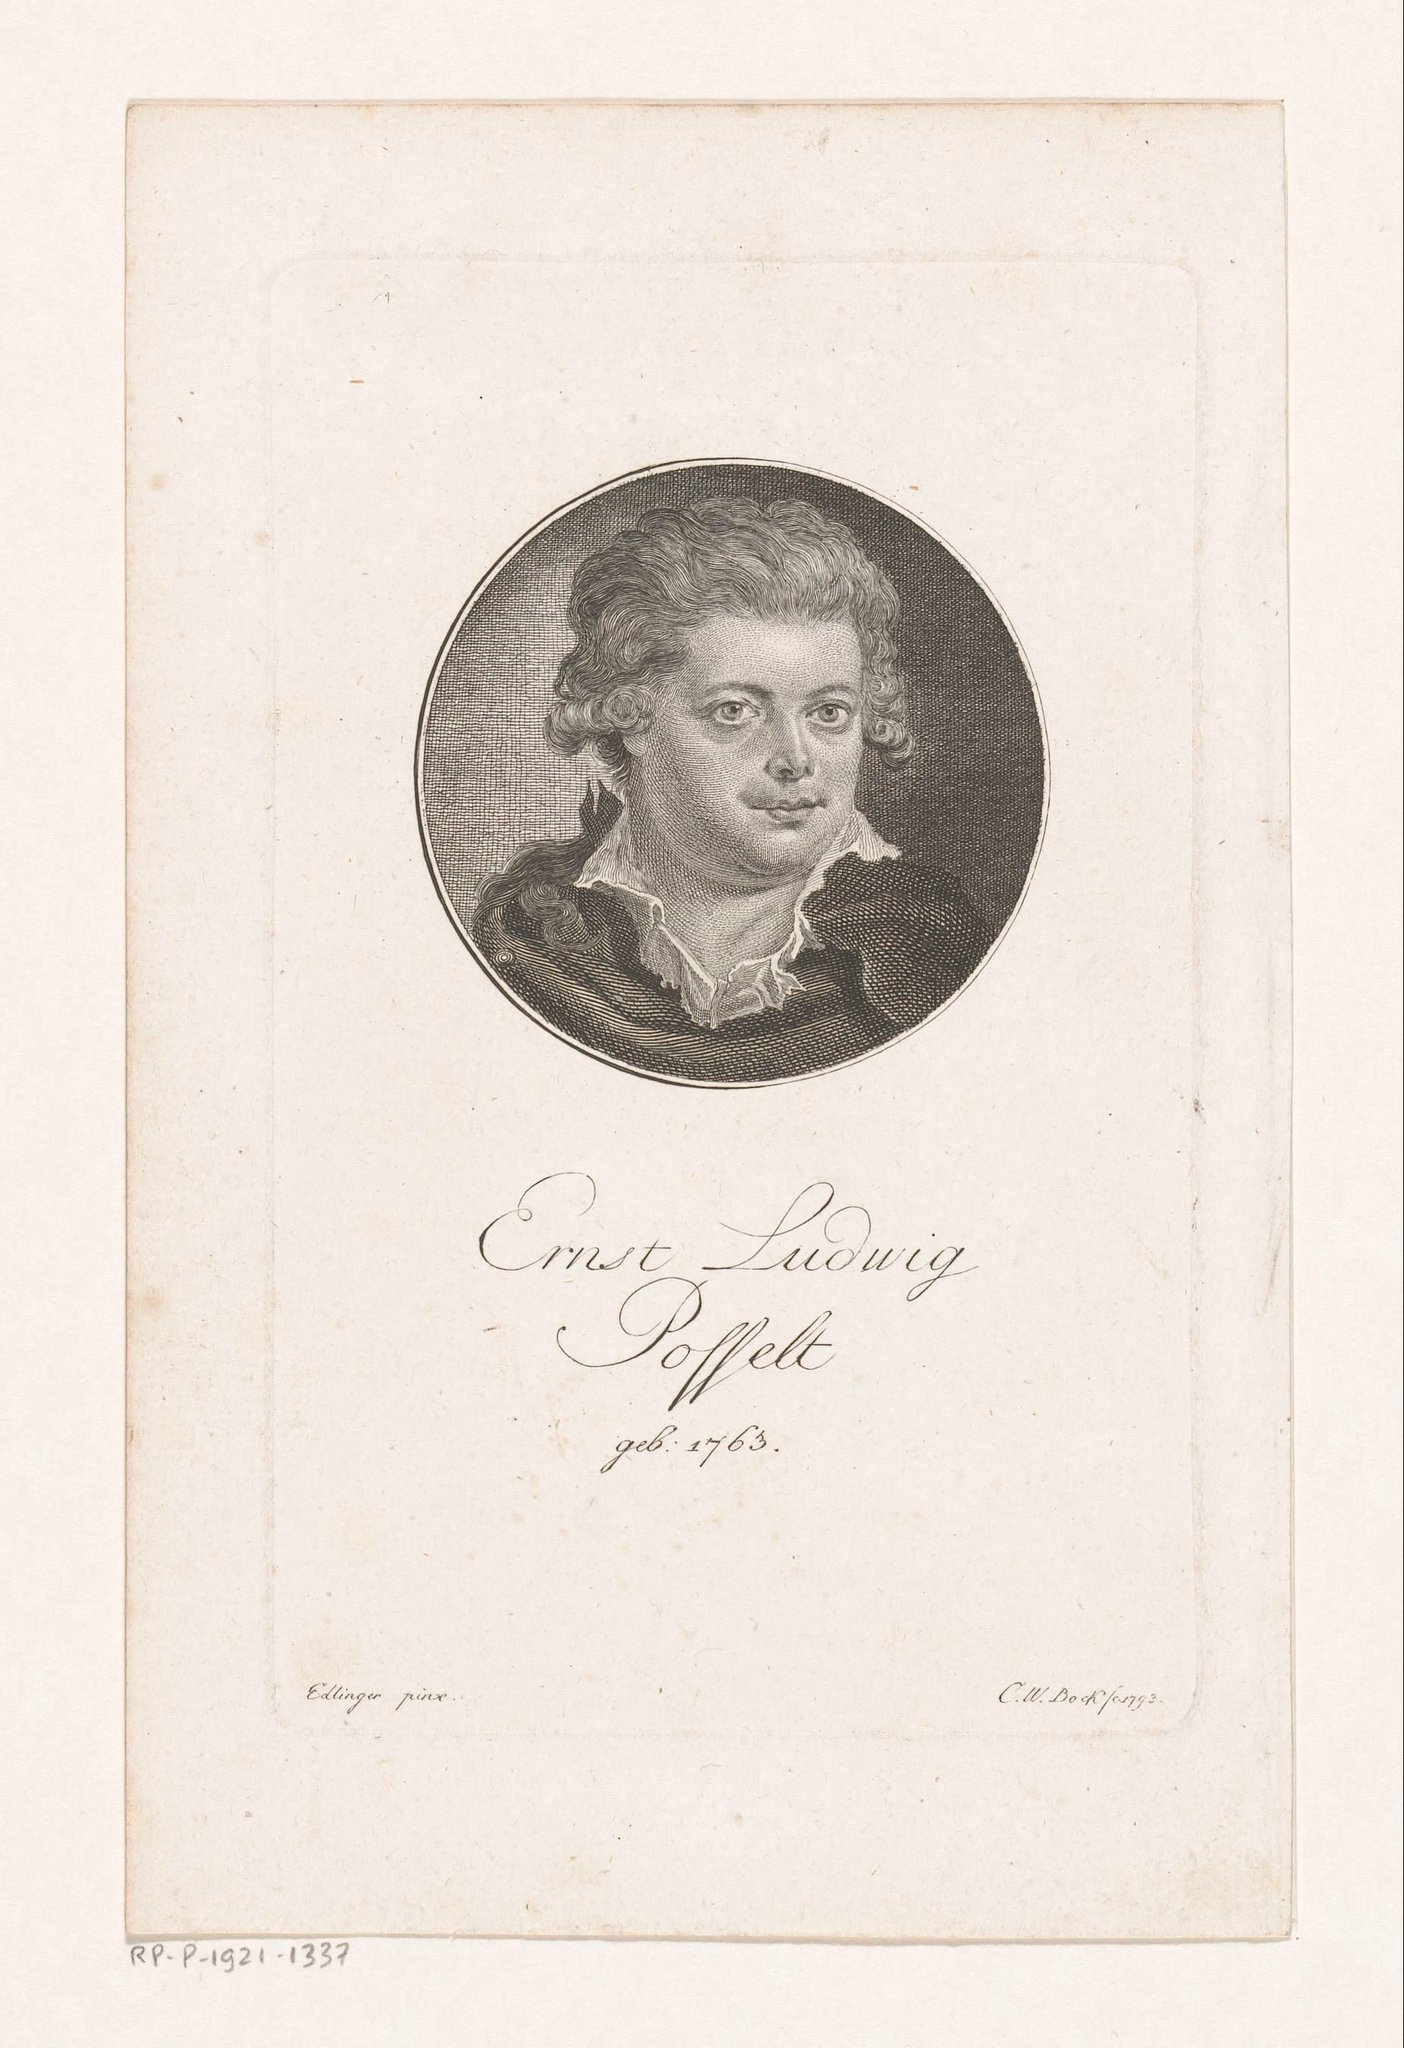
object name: print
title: Portret van Ernst Ludwig Posselt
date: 1793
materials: paper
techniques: engraving, etching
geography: nuremberg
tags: historical persons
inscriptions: collector's mark: Lugt 2233